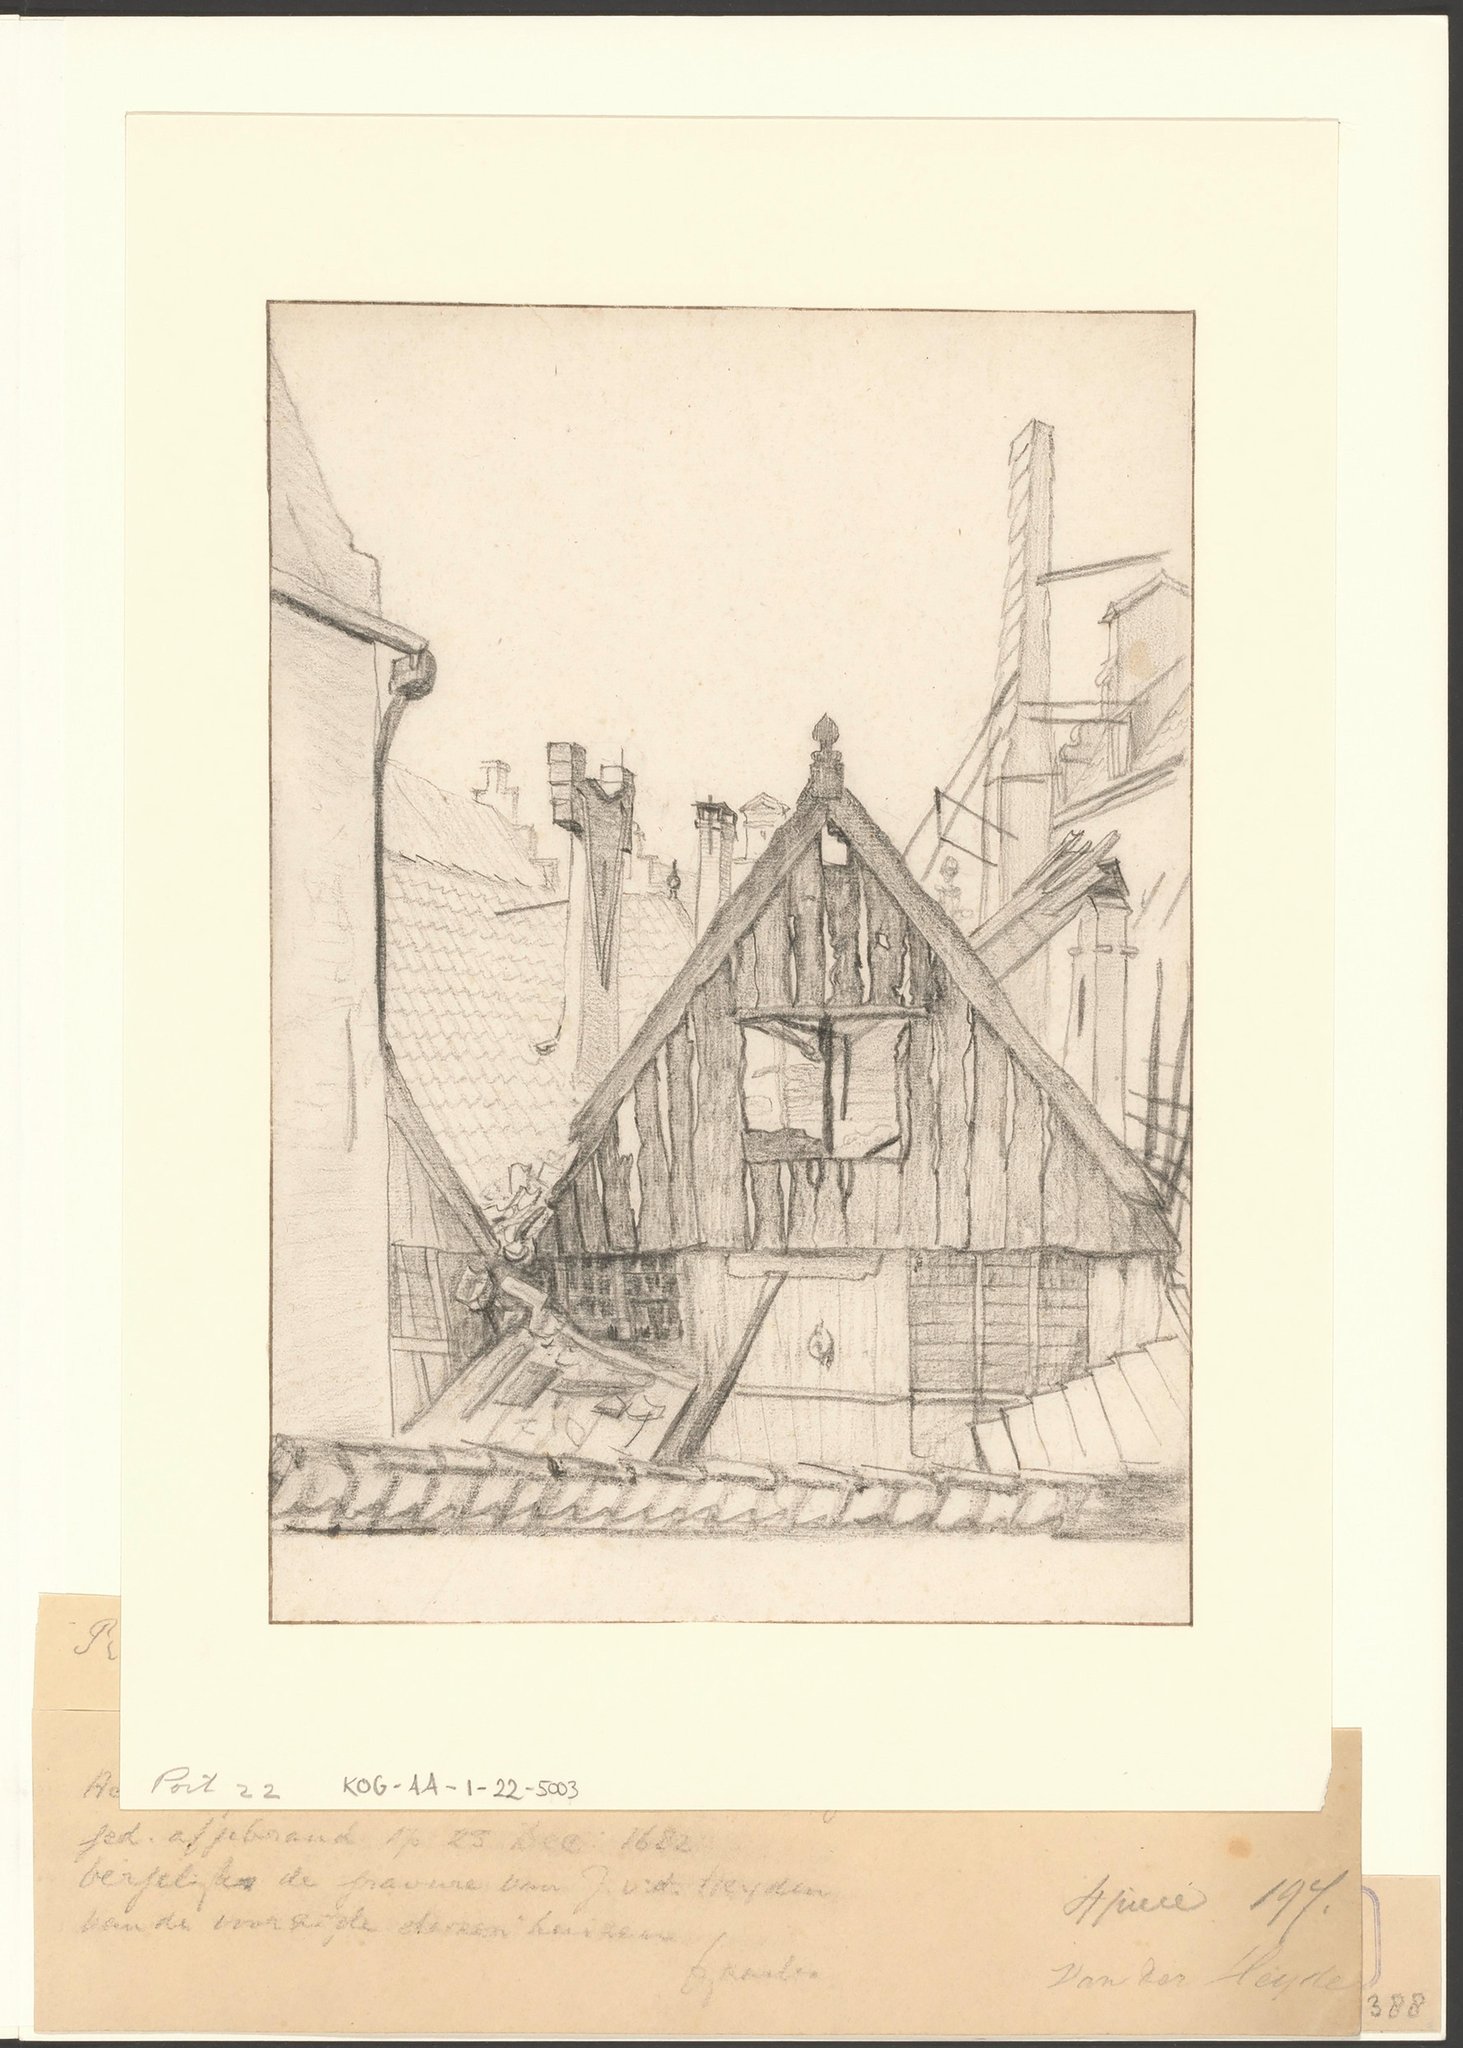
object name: drawing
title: Gezicht op de achterkant van een door brand aangetaste houten gevel in de Goudsbloemstraat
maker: jan van der heyden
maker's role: draughtsman, painter, print maker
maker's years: 1637-1712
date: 1647-1712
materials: chalk, paper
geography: amsterdam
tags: city-view in general; 'veduta', rear façade, ordeal by fire or heat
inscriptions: inscription: ‘Port. 22’, collector's mark: ‘22’ Lugt 1641b, inscription: ‘Achterzijde van 2 (...) van der Heyde’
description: Onderwerpsrubriek binnen de Atlas Amsterdam: Branden in particuliere gebouwen; Gemeentebedrijven.